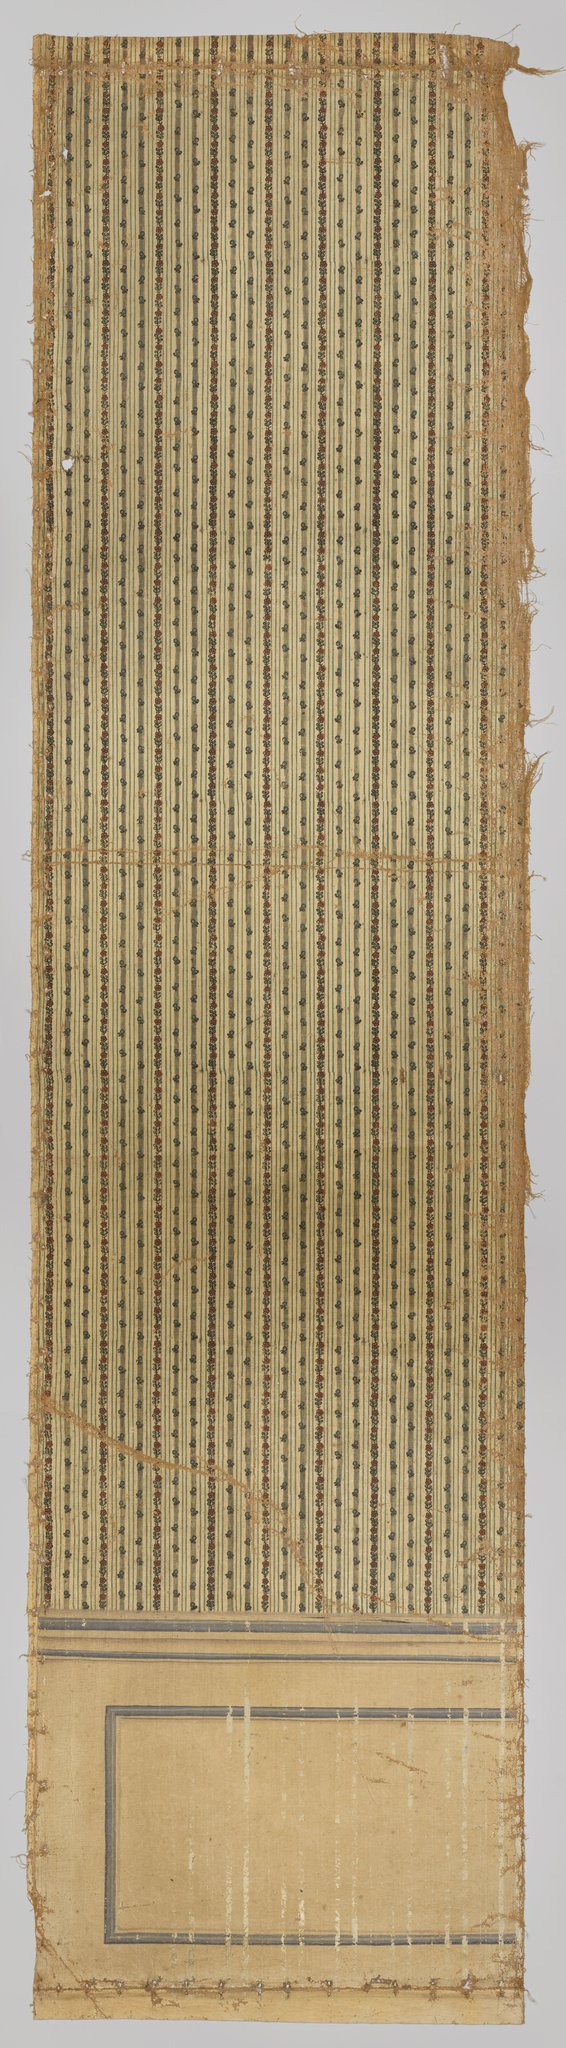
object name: interieuronderdeel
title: Drie banen van op linnen geschilderd behangsel met verticale strepen afwisselend versierd met takken met bessen en een bloemenrank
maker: Anonymous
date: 1785-1800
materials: linen, oil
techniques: painted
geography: netherlands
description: Drie banen in olieverf op linnen geschilderd behangsel. Boven een lambris van gebroken wit met blauwgrijze omlijstingen, zijn op een gebroken wit fond grijsblauwe verticale strepen aangebracht, afwisselend versierd met gestrooide takjes met bessen en een bloemenrank in rood en blauw.